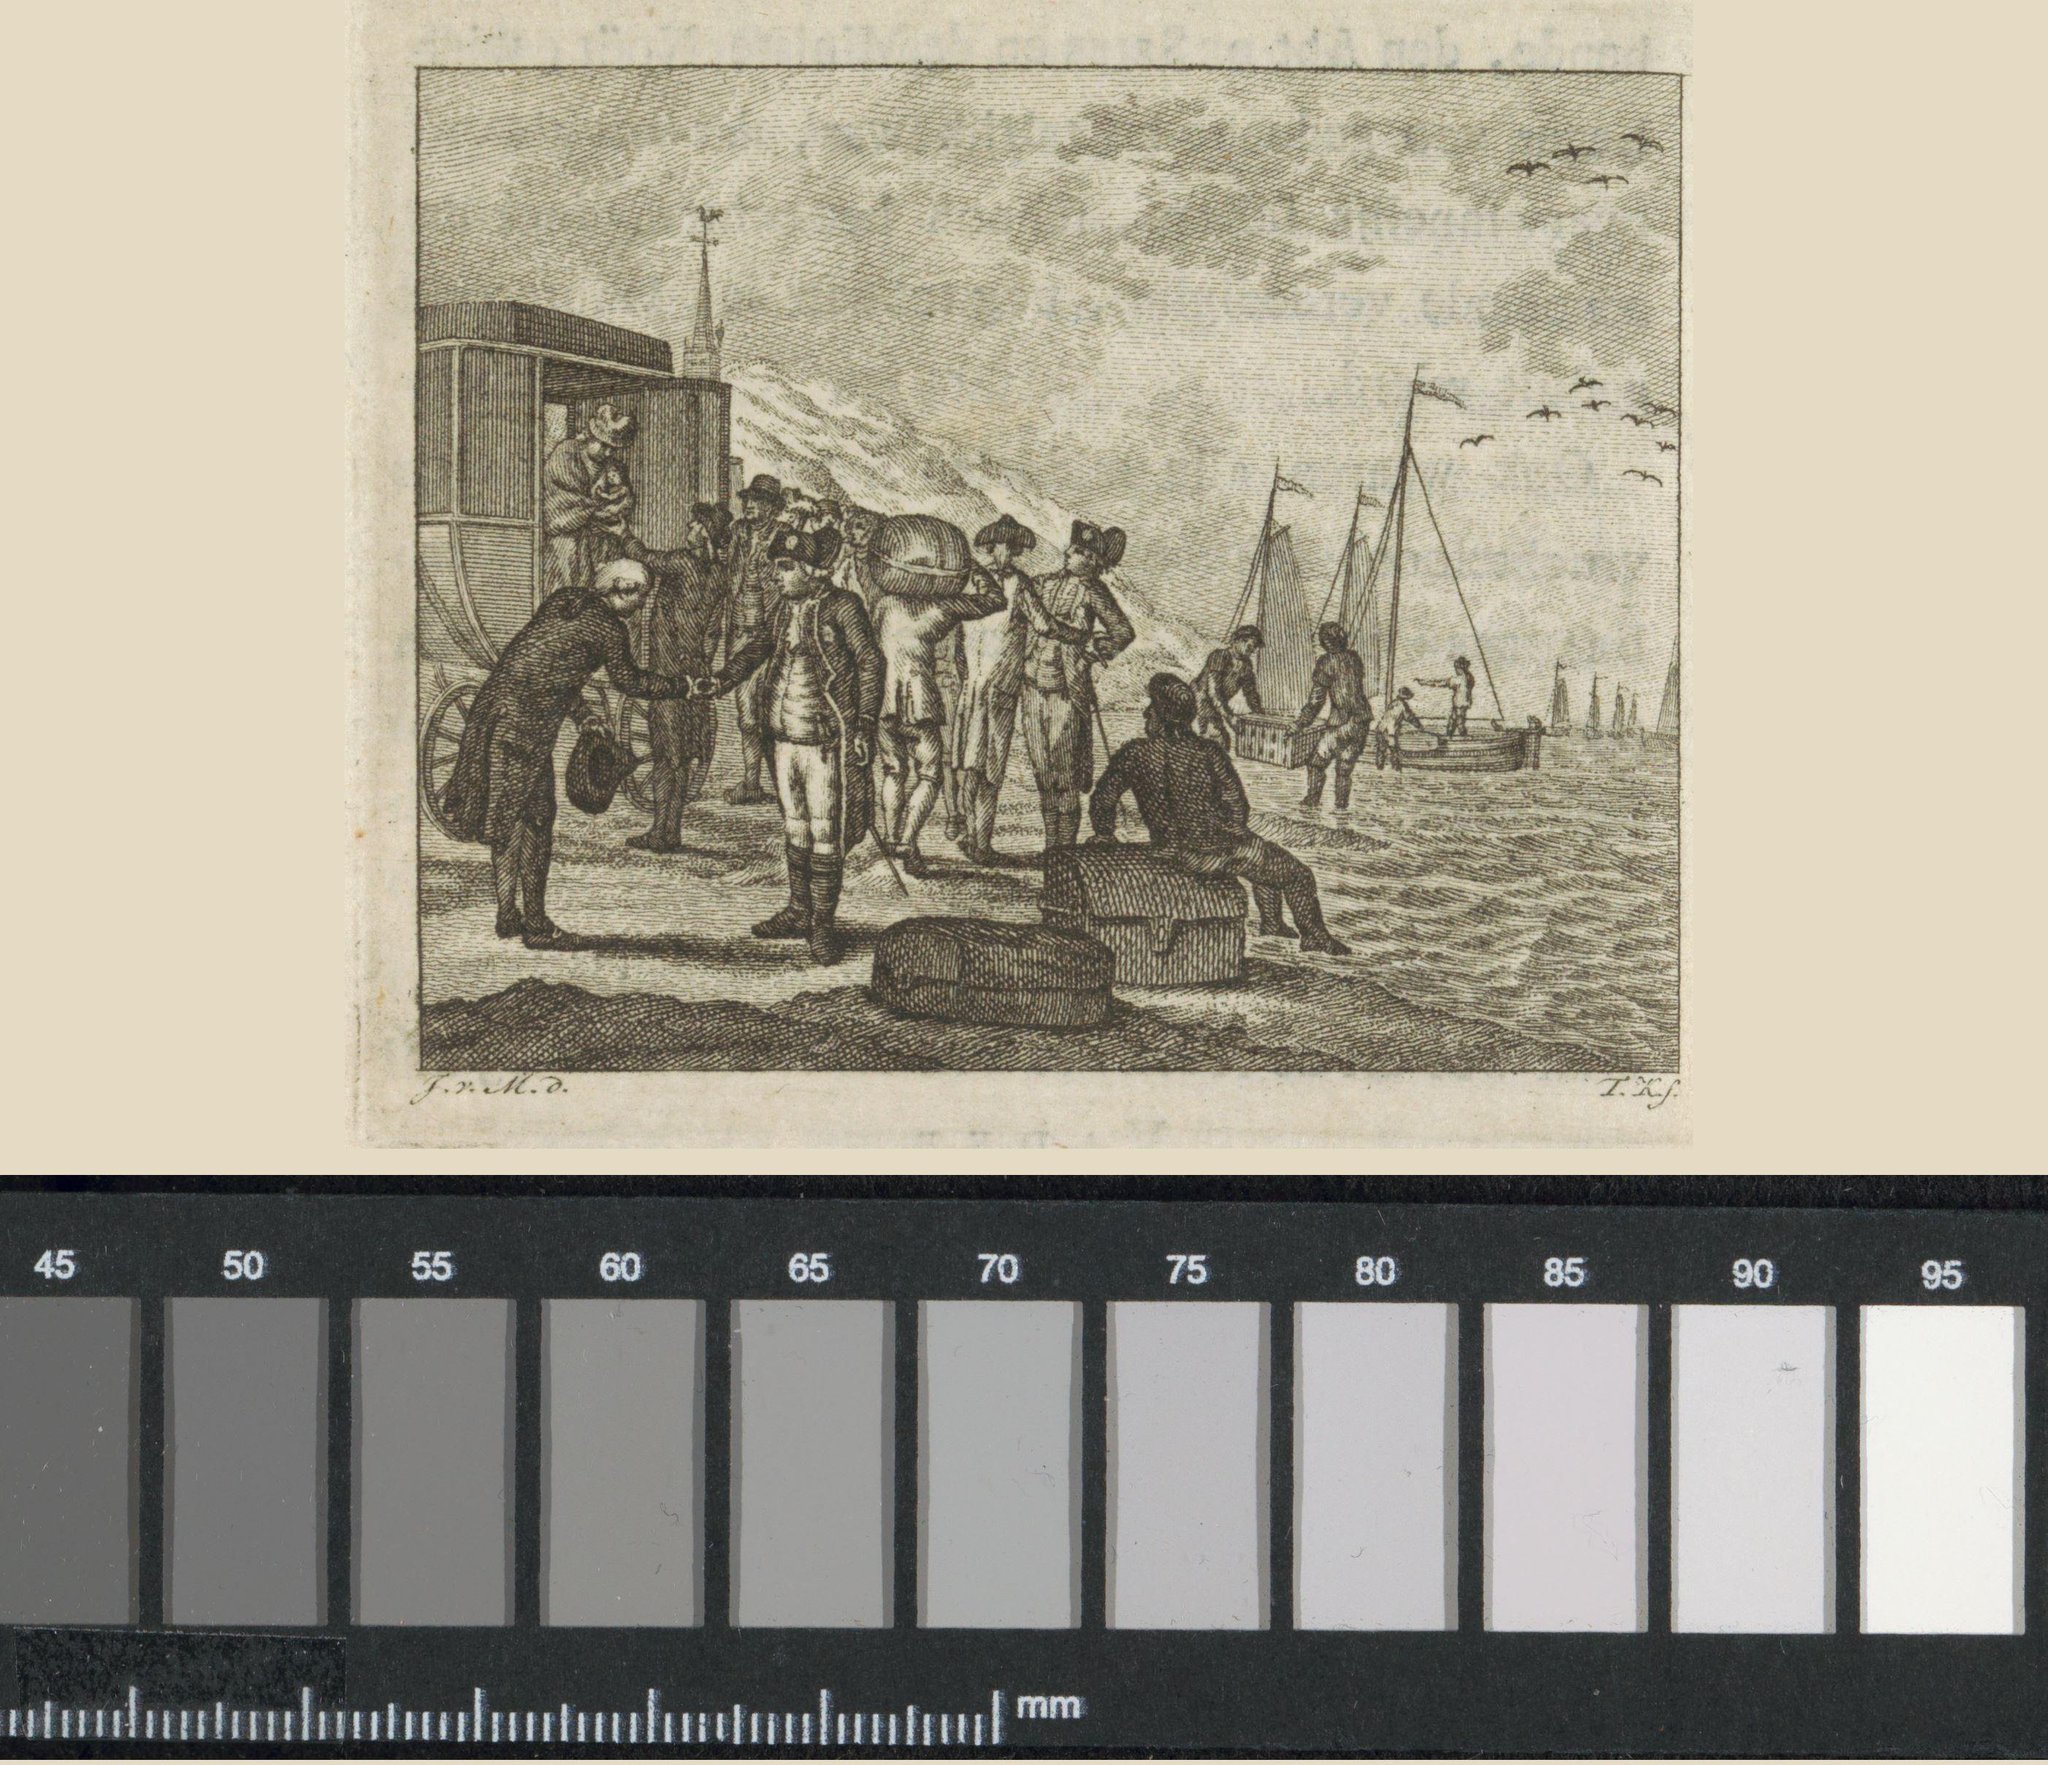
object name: book illustration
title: Vertrek van Willem V uit Scheveningen, 1795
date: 1795-1796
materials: paper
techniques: etching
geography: amsterdam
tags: departure ~ travelling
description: Vertrek van prins Willem V uit Scheveningen naar Engeland, 18 januari 1795. De prins schudt de hand van een buigende man. Illustratie op p. 258 van het boek: Historie der omwentelingen.